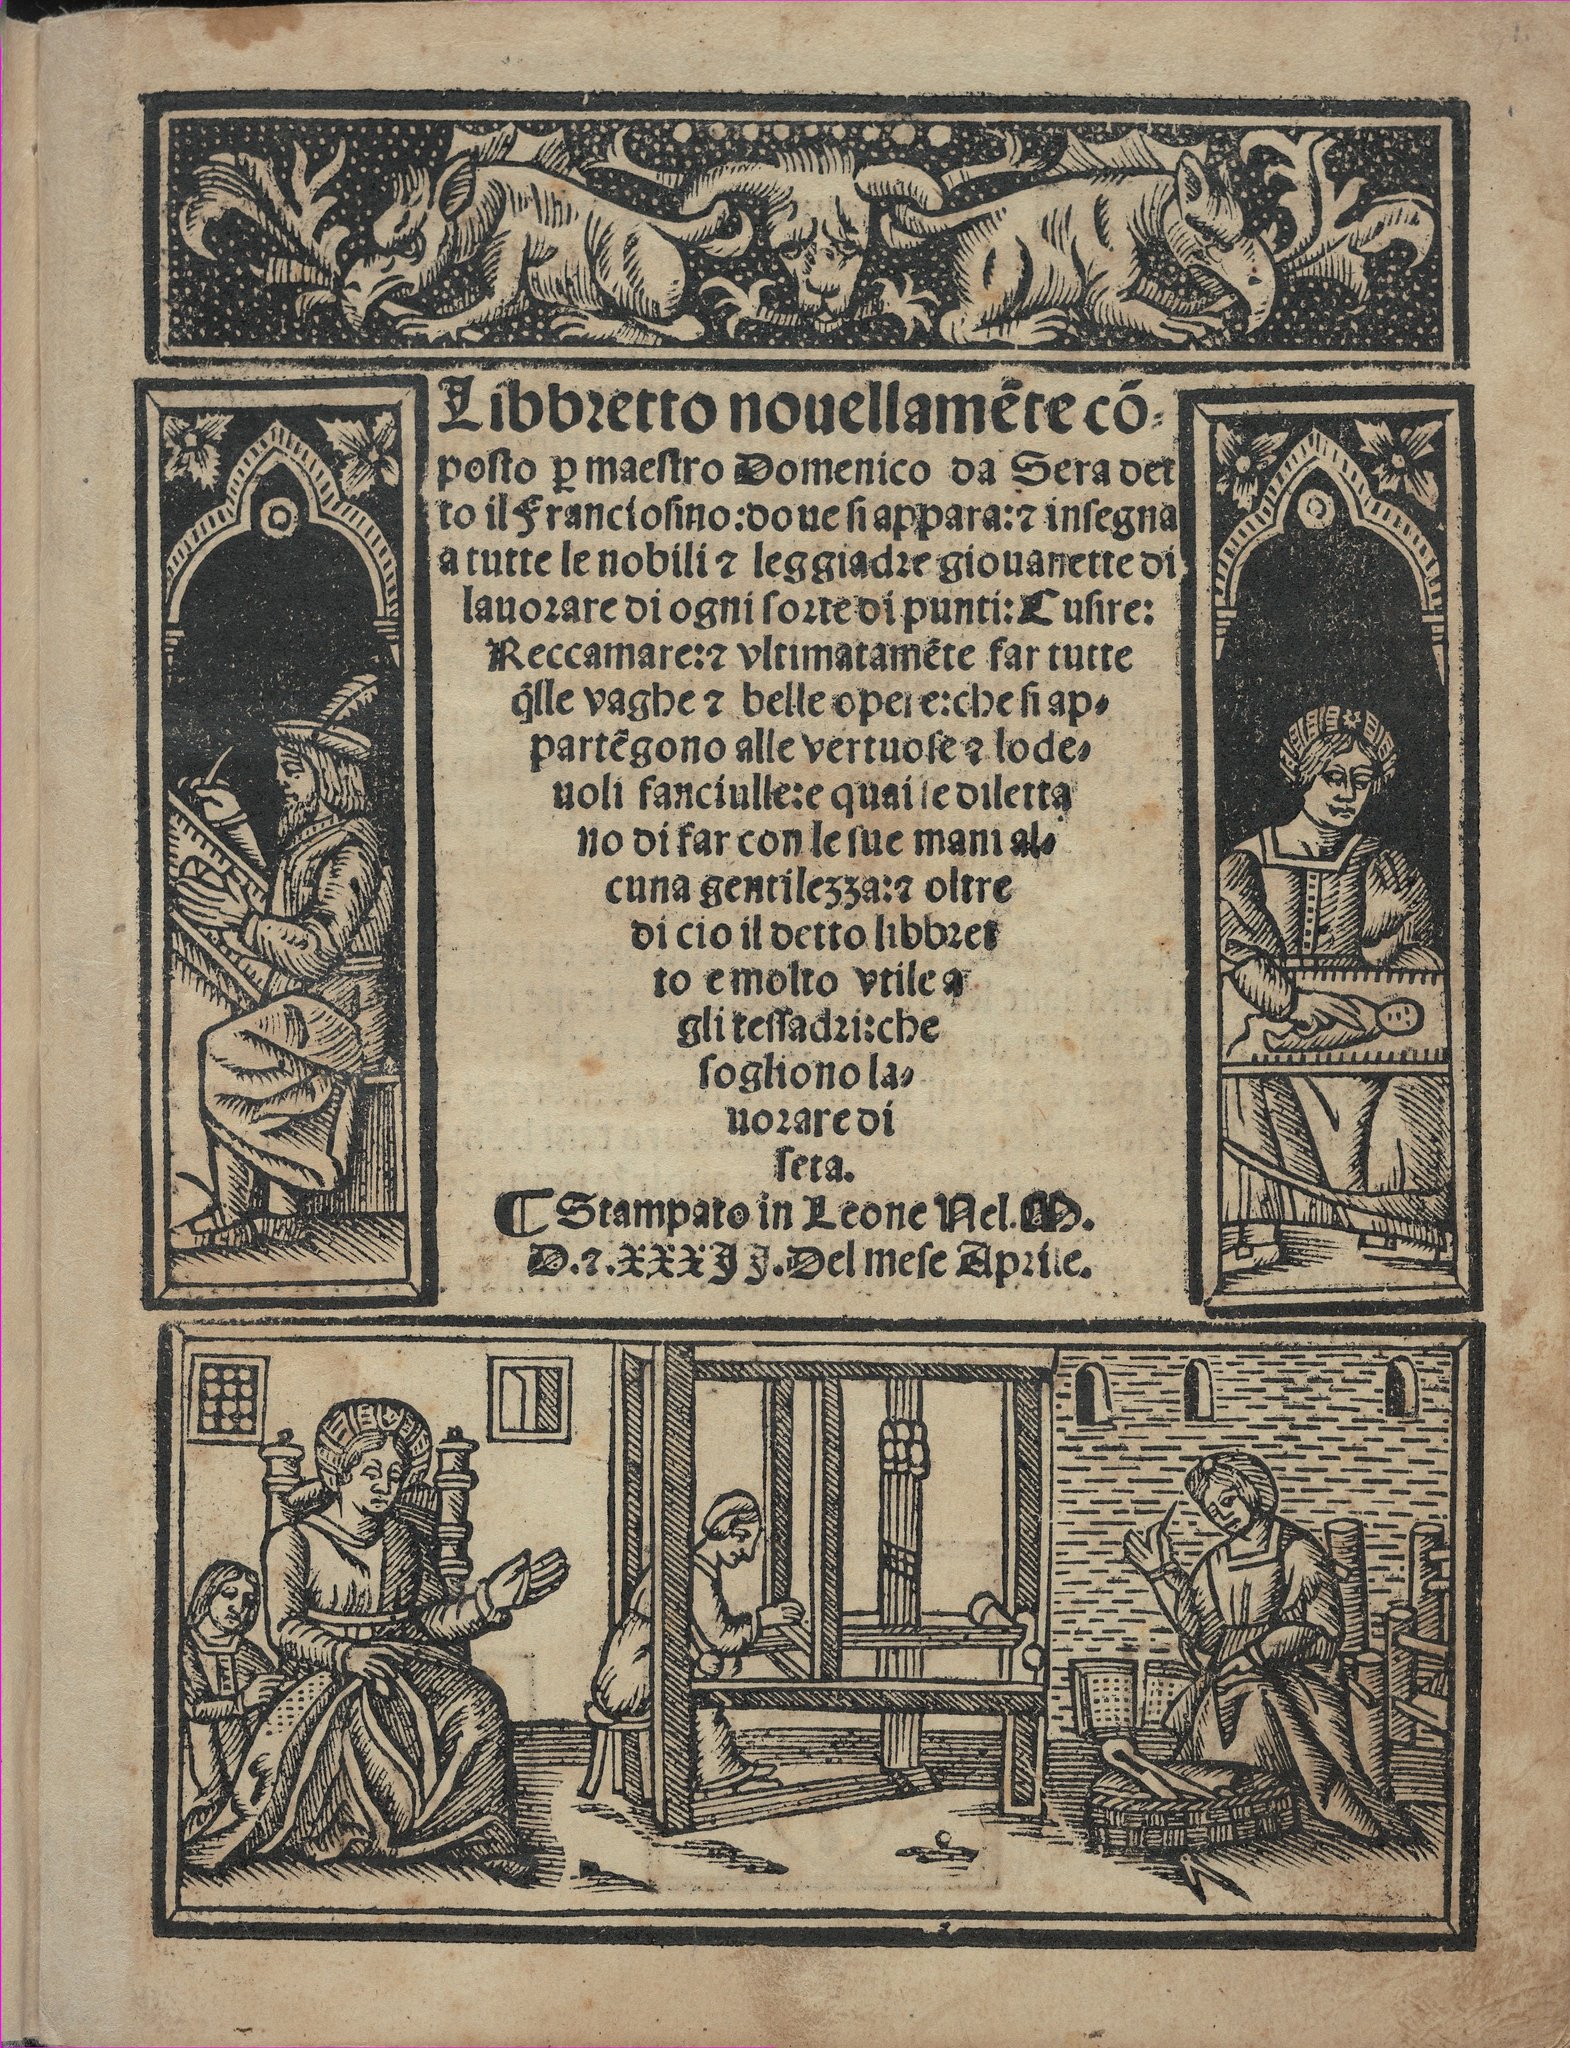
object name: book print ornament architecture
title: Libbretto nouellamete composto per maestro Domenico da Sera...lauorare di ogni sorte di punti, title page (recto)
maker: domenico da sera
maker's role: artist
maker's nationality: french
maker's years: 1500-1599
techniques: woodcut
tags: men,women,working